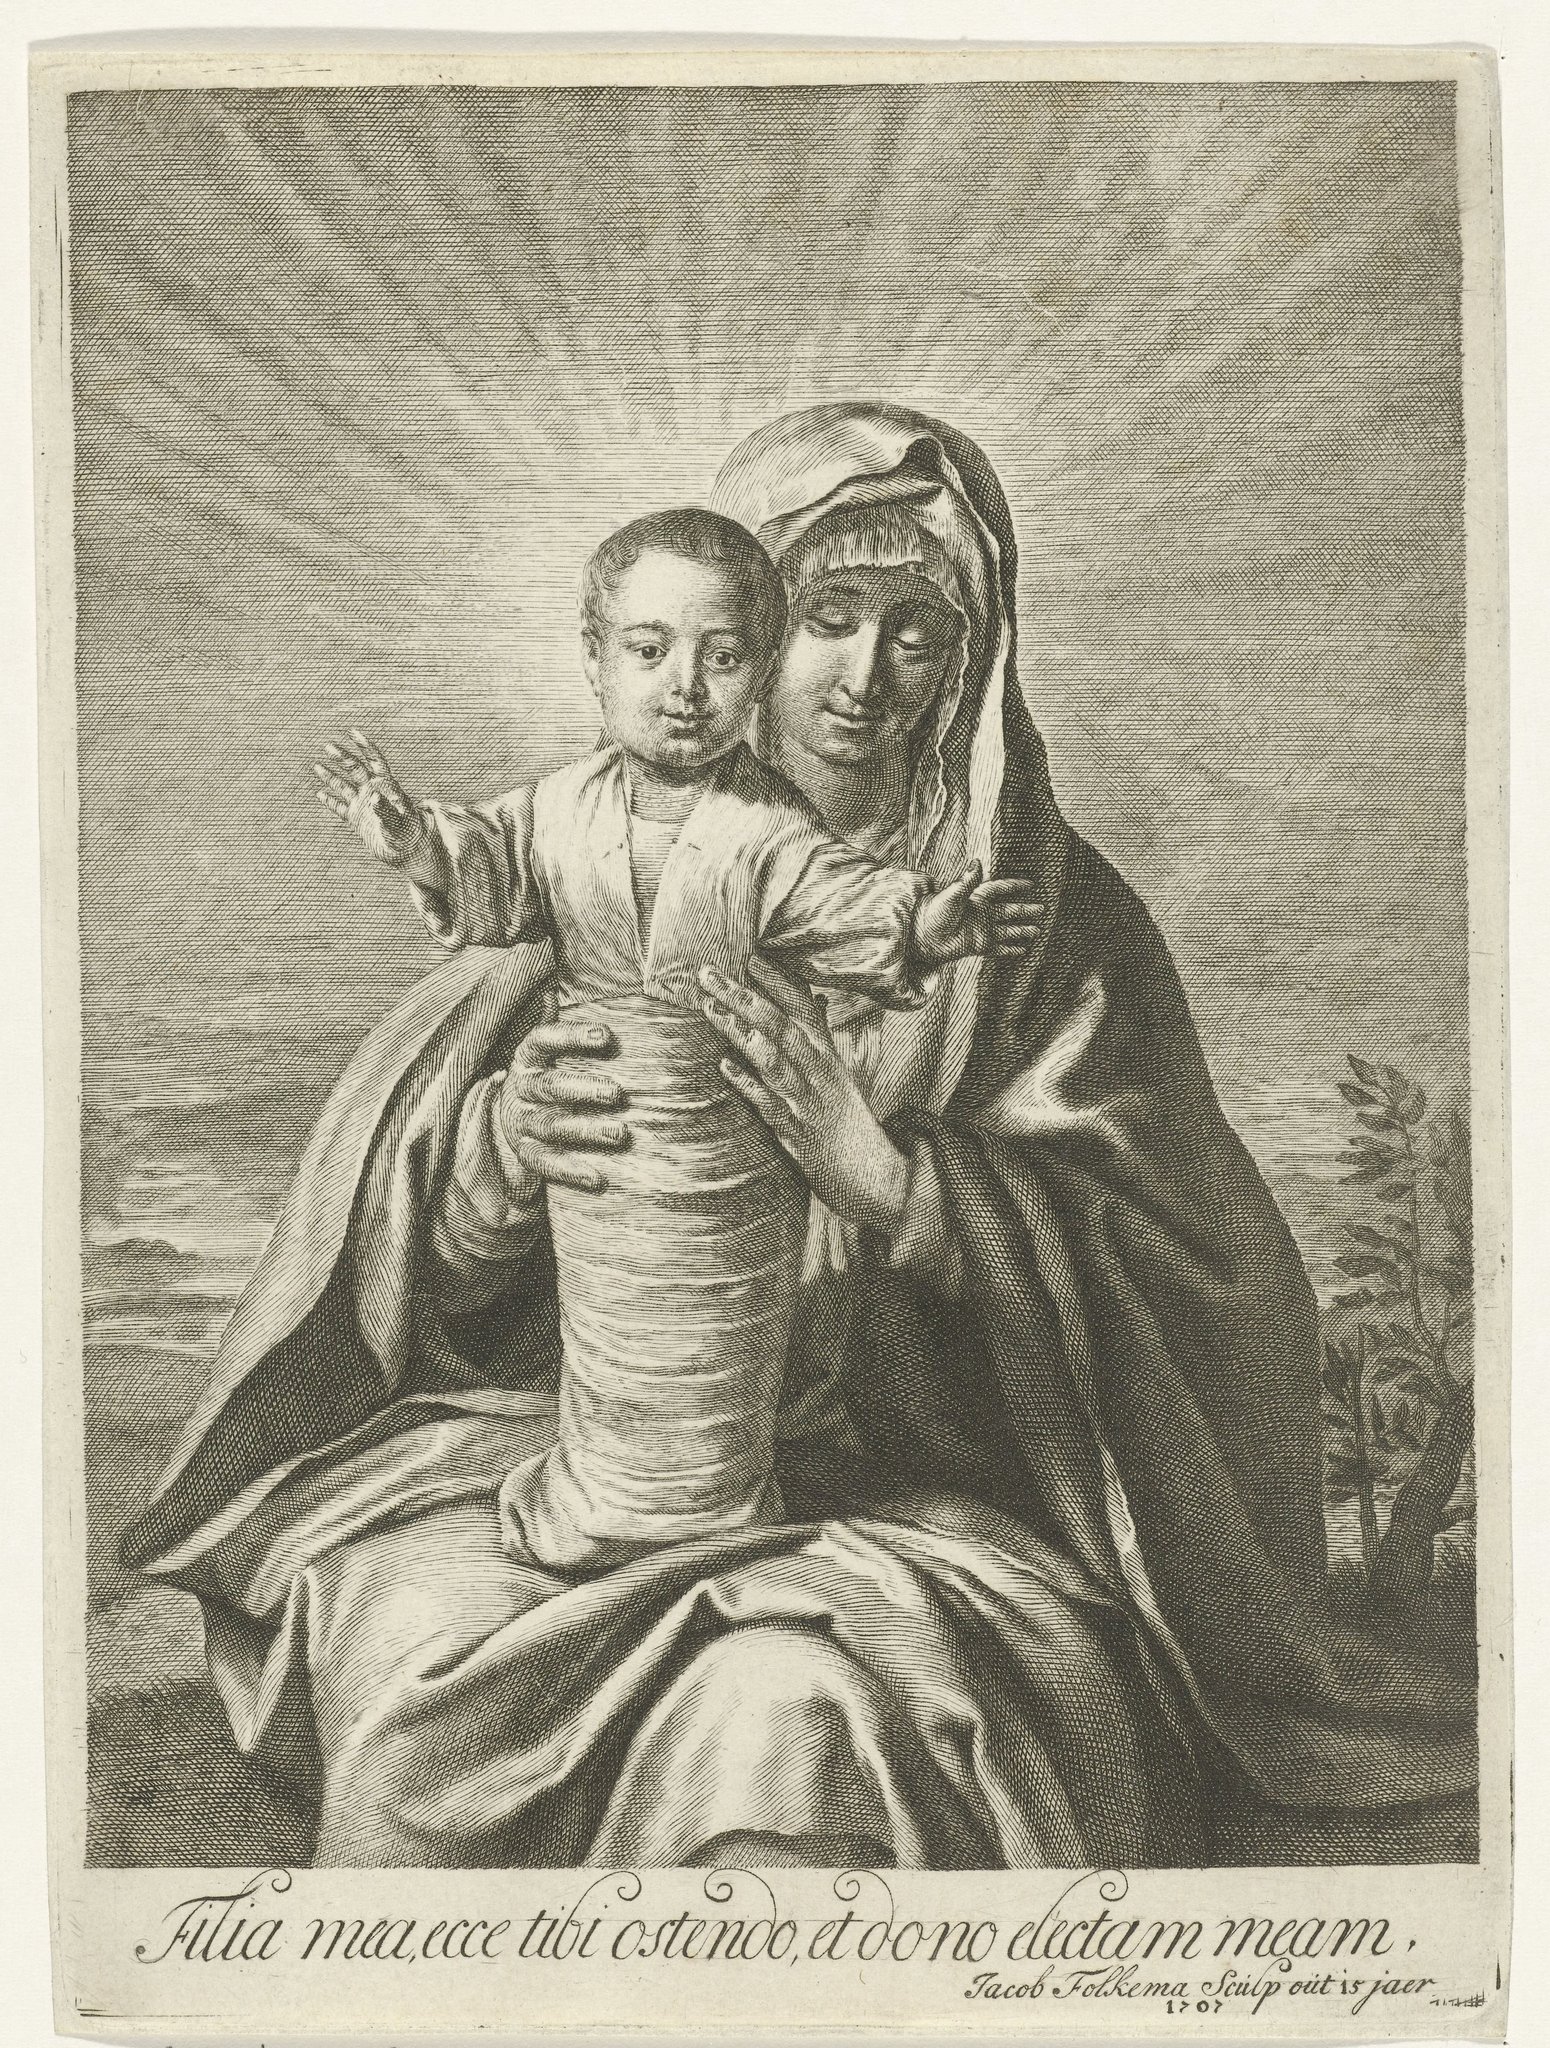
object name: print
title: Maria met kind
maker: jacob folkema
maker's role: draughtsman, print maker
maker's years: 1692-1767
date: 1707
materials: paper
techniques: engraving, etching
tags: mary sitting or enthroned, the christ-child in front of her, standing in her lap (or in front of her bosom)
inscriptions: inscription: ‘Jacob Folkema Sculp out 15 jaer 1707’, collector's mark: Lugt 2228, inscription: ‘Filia mea, ecce tibi ostendo, et dono electam meam’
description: Maria met het ingebakerde Christuskind, staand op haar schoot. Onder de voorstelling staat in de marge een handgeschreven onderschrift in het Latijn.